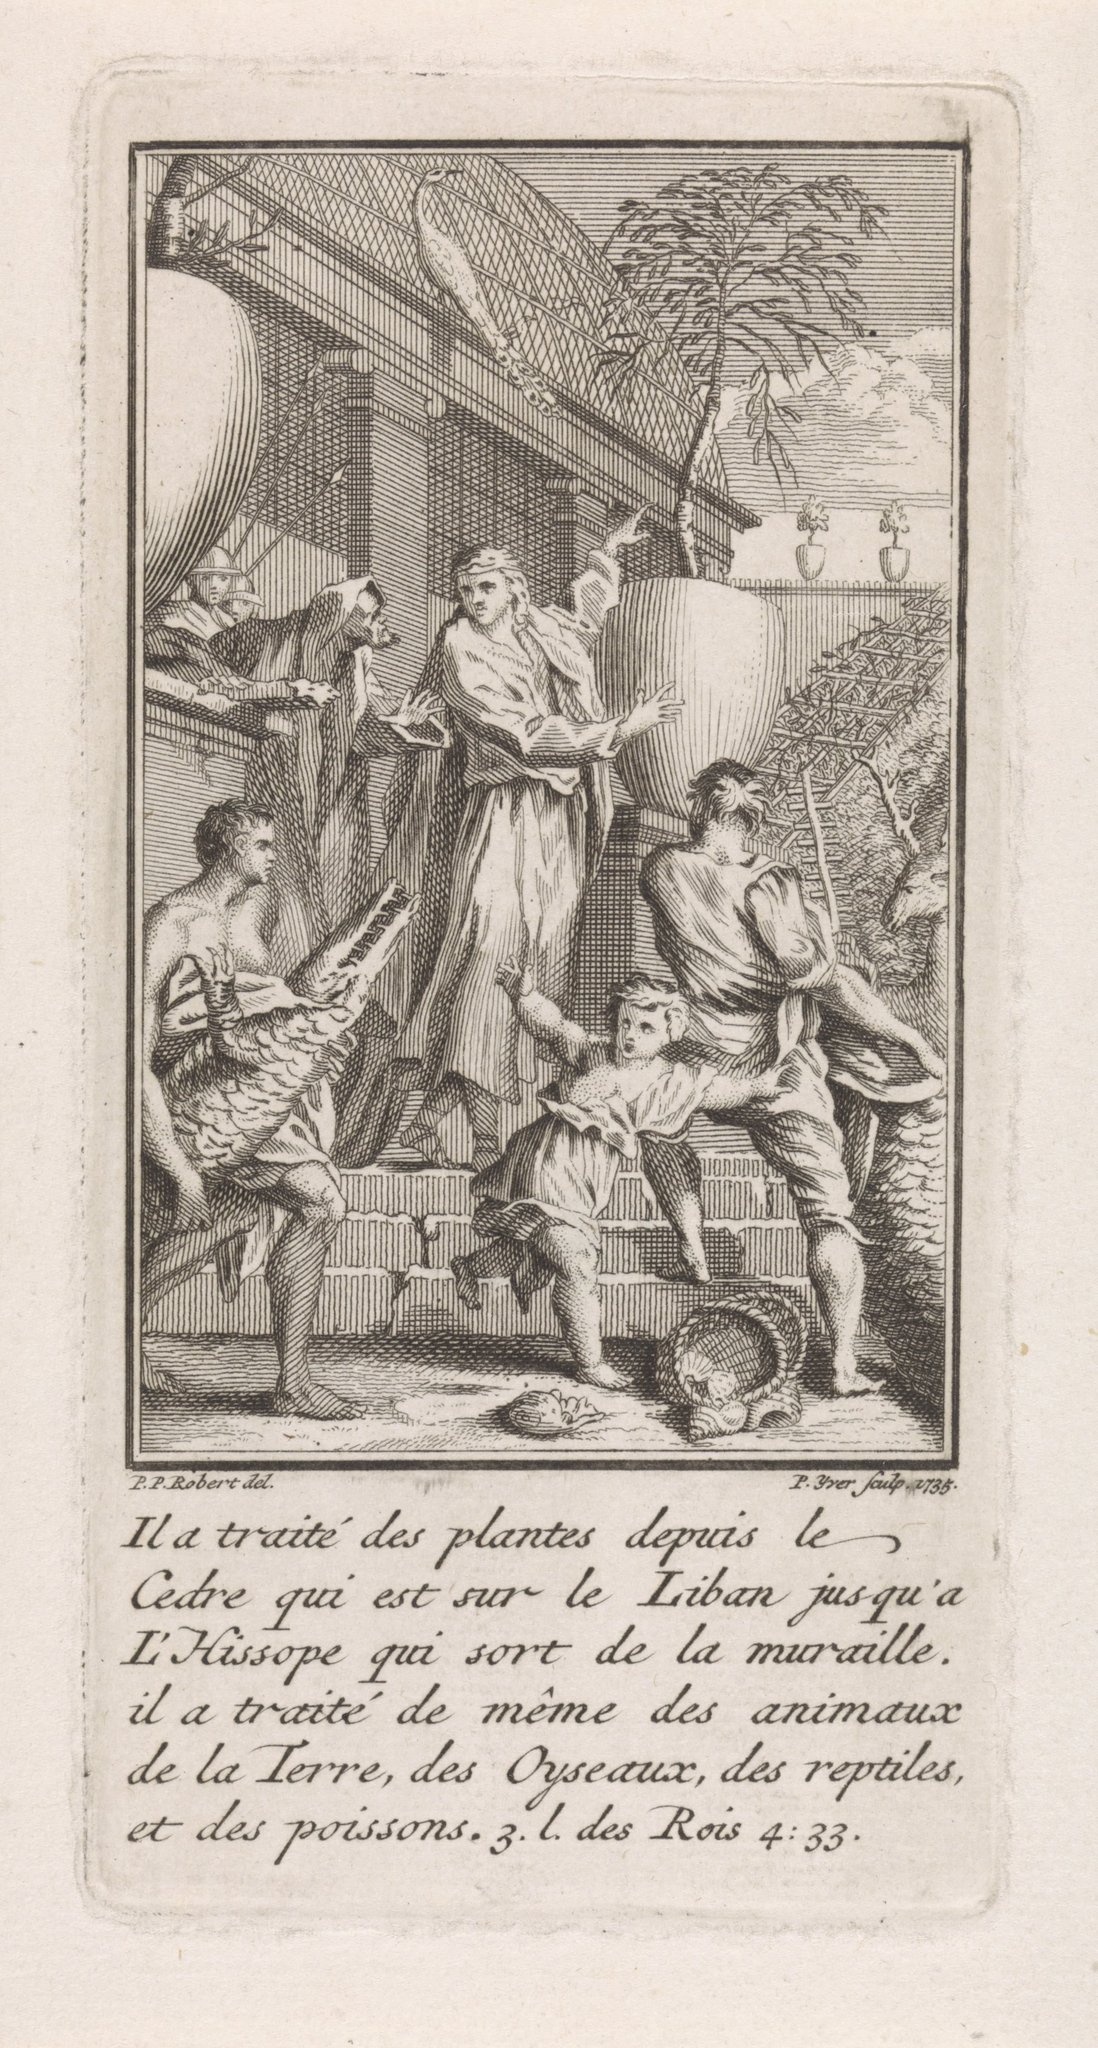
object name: book illustration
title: Koning Salomo te midden van planten en dieren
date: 1735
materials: paper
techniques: engraving, etching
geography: amsterdam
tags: solomon's wisdom (+ variant)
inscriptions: collector's mark: Lugt 2228, collector's mark: Lugt 2760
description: Koning Salomo maakt spreuken en gezangen over allerlei soorten planten, van de ceder op de Libanon tot de majoraan die uit de muur groeit, en over de lopende dieren, de vogels, de kruipende dieren en de vissen. Salomo staat te midden van deze dieren en planten en wijst ze een oude man, die naast hem staat, aan. Onderaan een verwijzing naar de Bijbeltekst 1 Koningen 4:33 in het Frans.